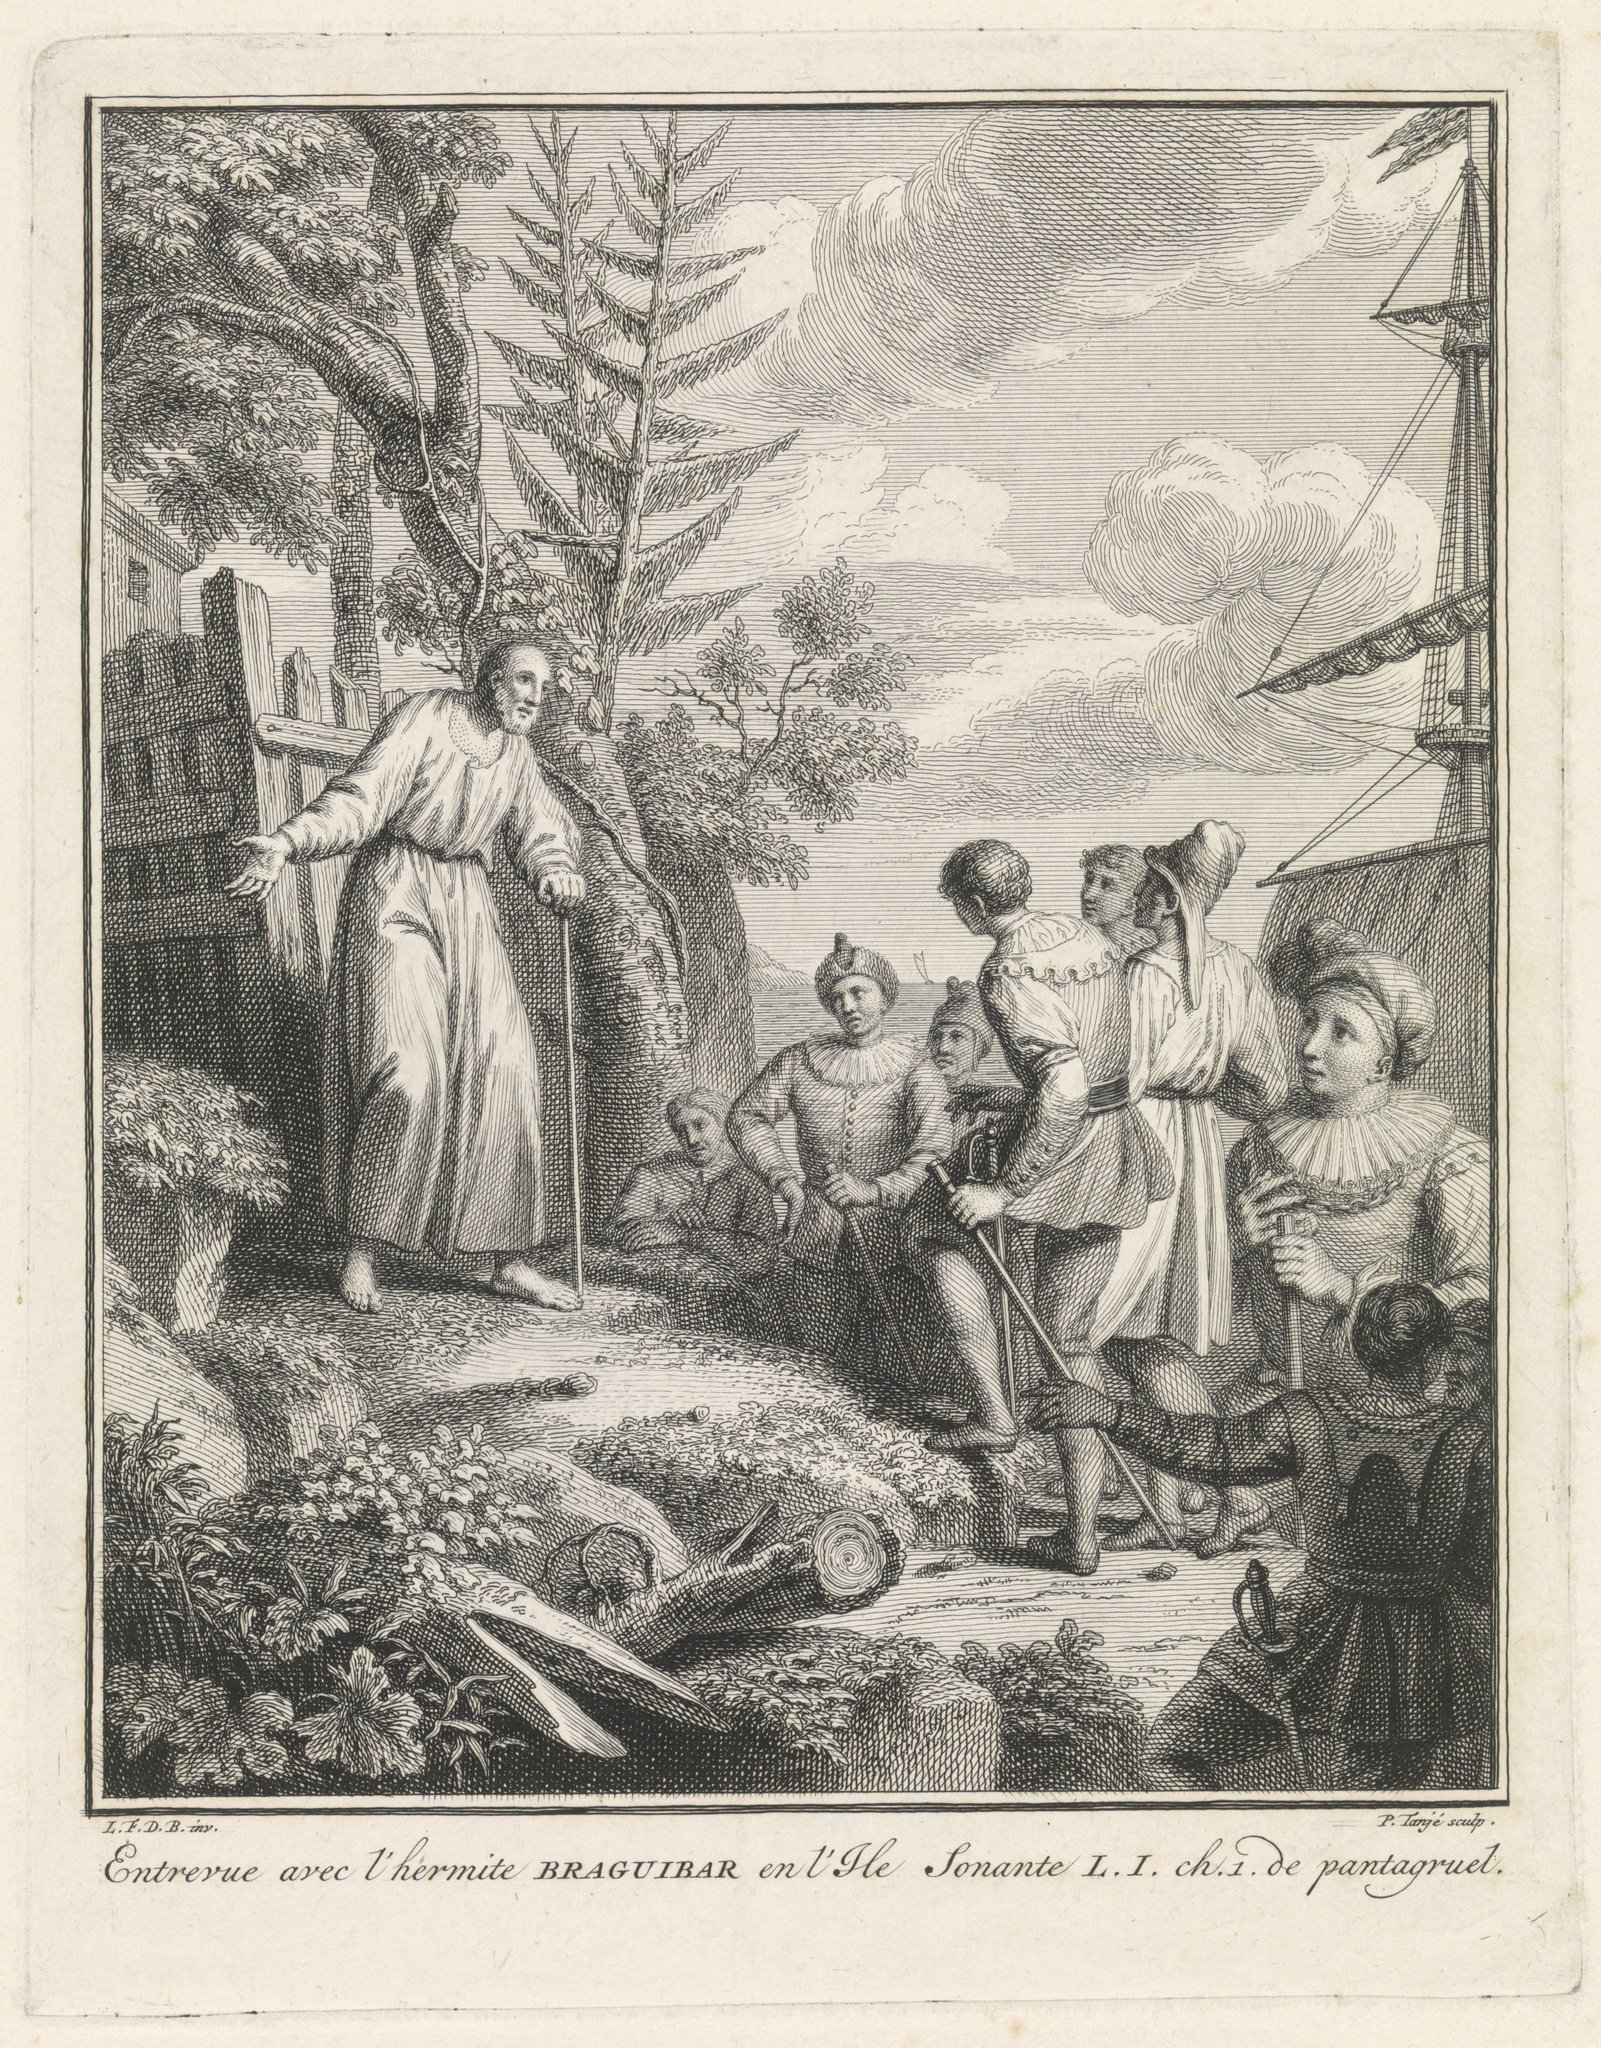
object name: print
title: Gargantua ontmoet een kluizenaar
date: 1716-1761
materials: paper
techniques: engraving, etching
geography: amsterdam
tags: anchorite, hermit, giants, colossi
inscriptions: collector's mark: Lugt 240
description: Gargantua en zijn medereizigers ontmoeten een monnik en kluizenaar op het eiland. Illustratie bij de verhalen van François Rabalais over Pantagruel en Gargantua. In de marge staat een regel tekst in het Frans, rechtsonder gemerkt: L. I. Ch. 1.